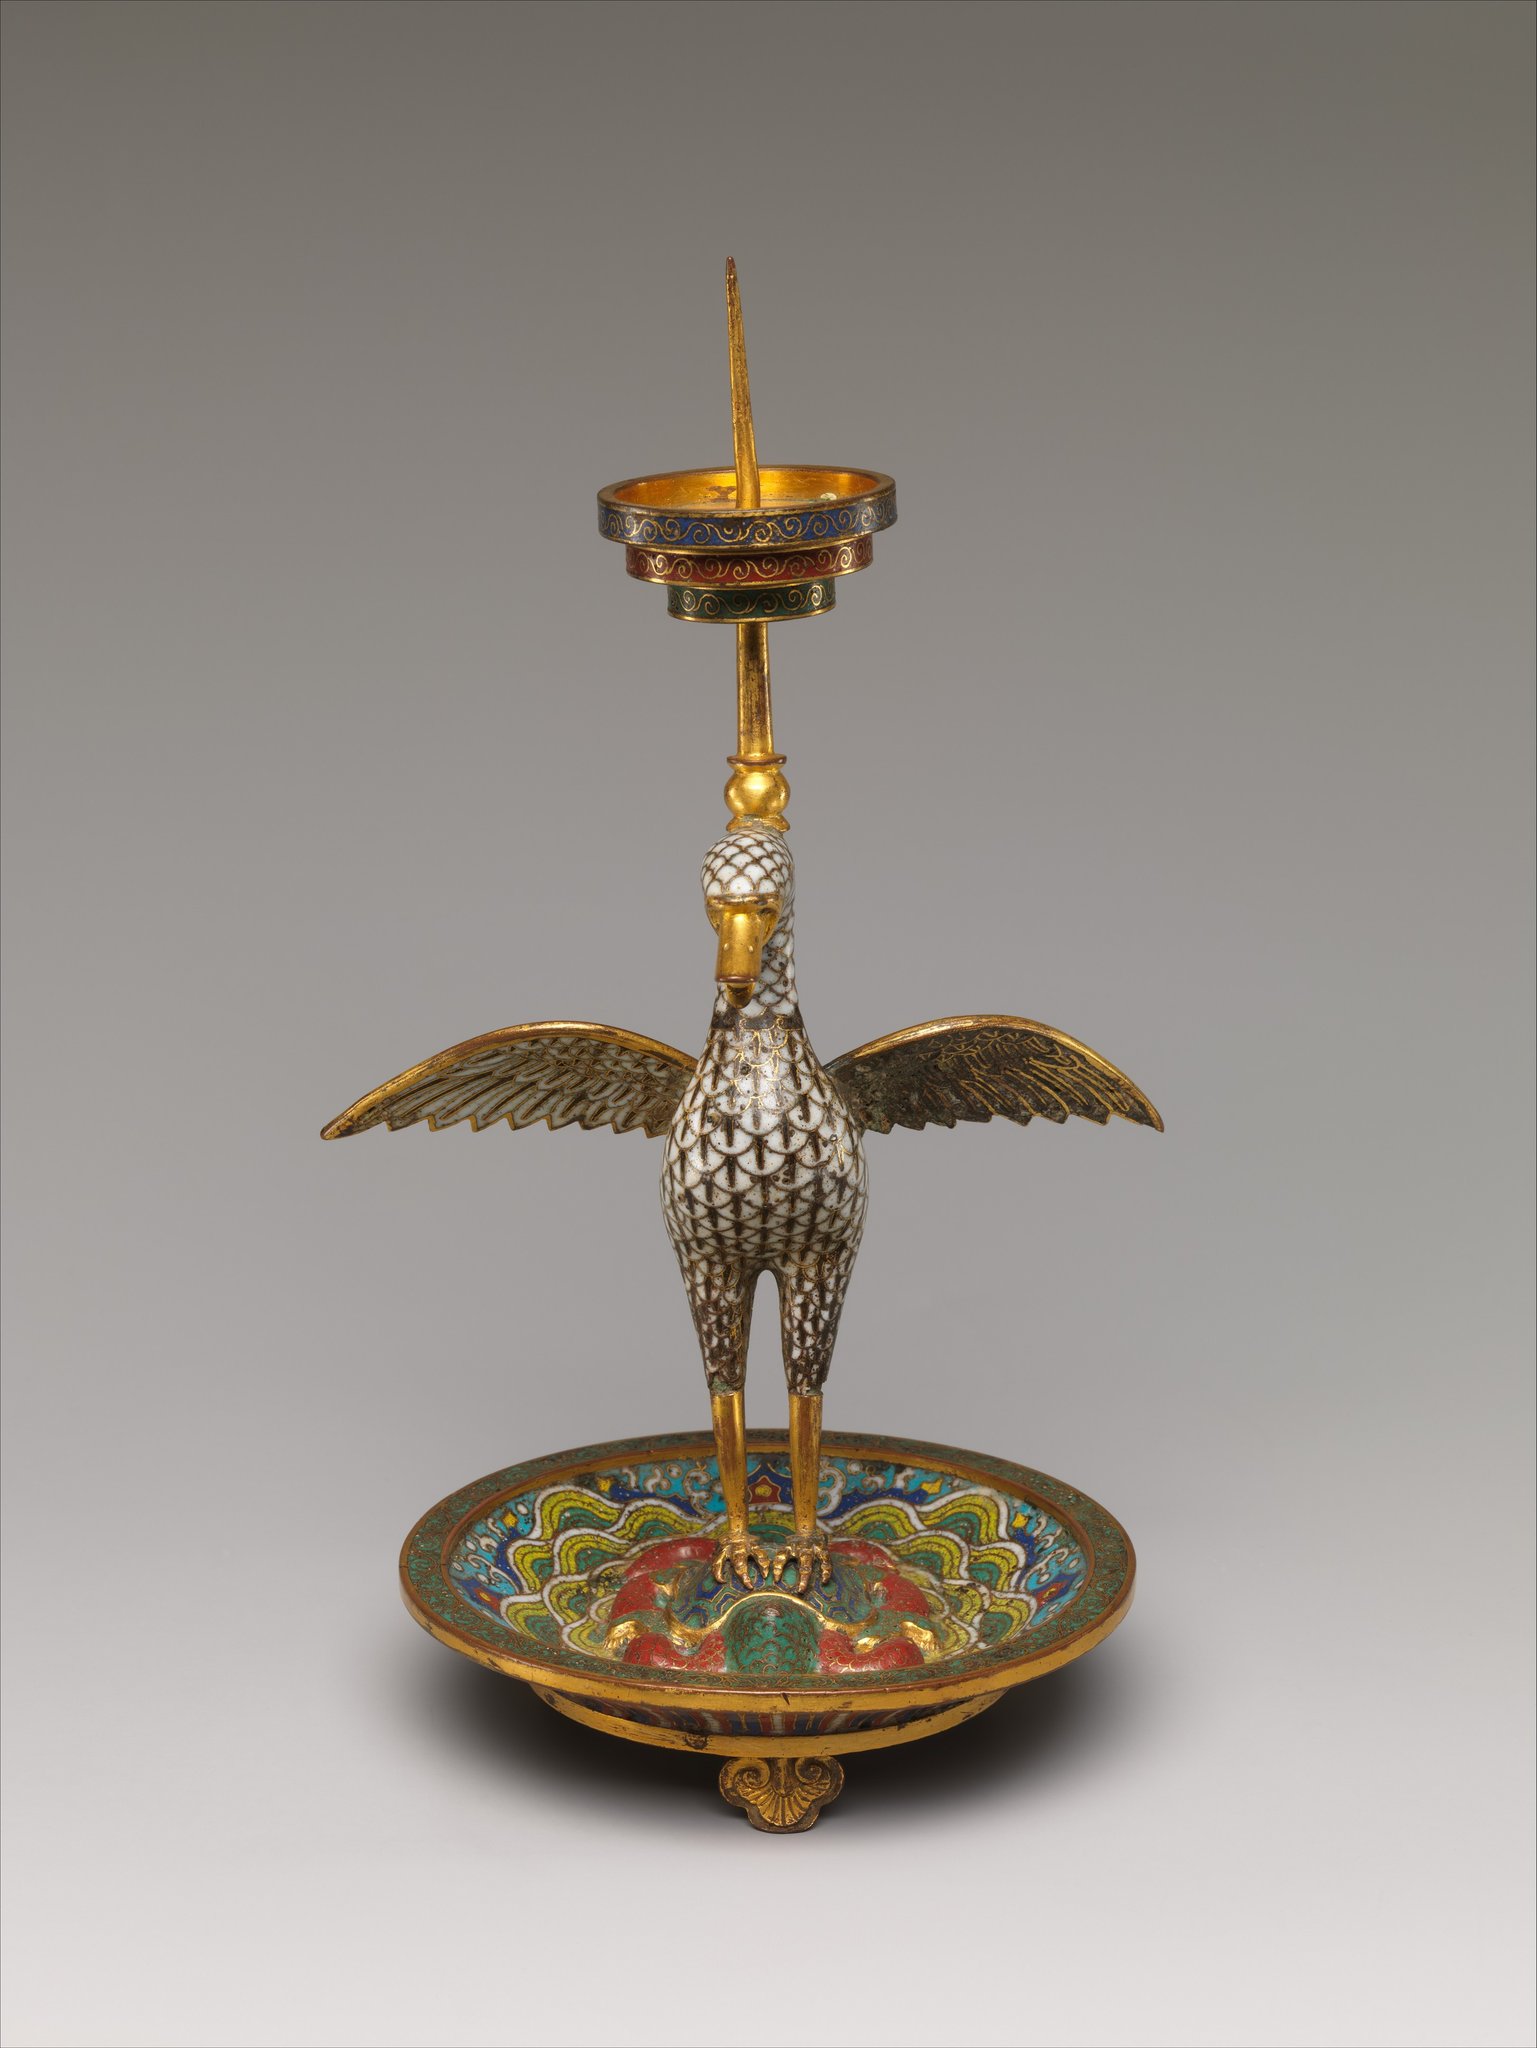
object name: candlestick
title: Candlestick (one of a pair)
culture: chinese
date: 1736-1795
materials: enamel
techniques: enamel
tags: birds